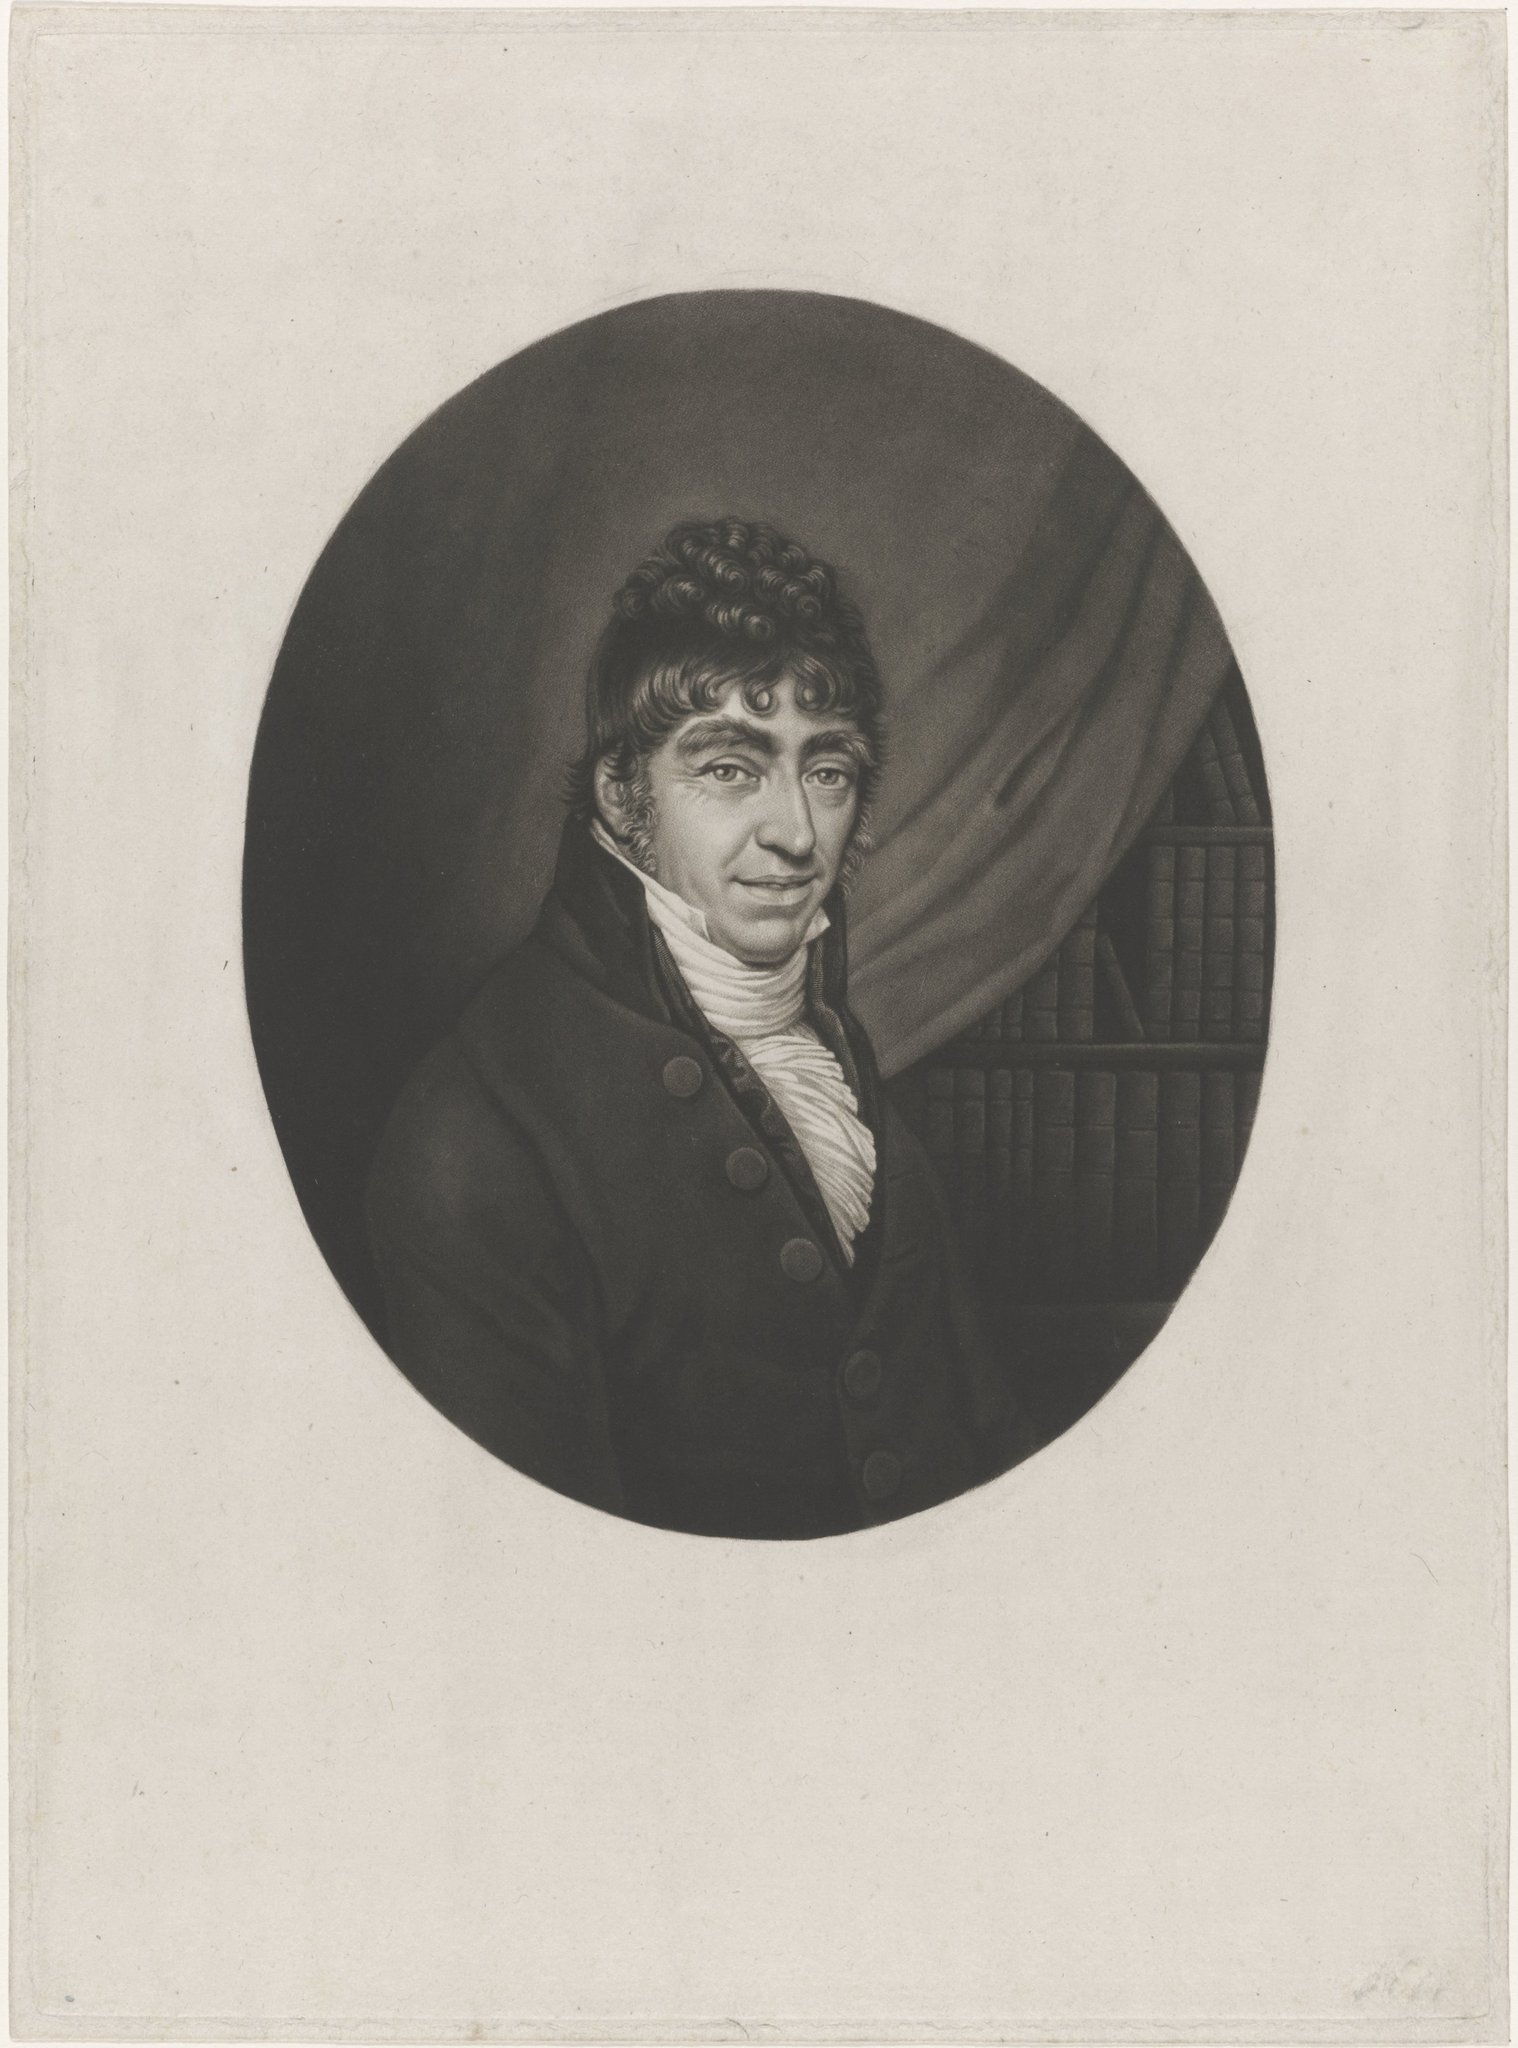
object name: print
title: Portret van Willem Bilderdijk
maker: willem grebner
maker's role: draughtsman, print maker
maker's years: 1784-1866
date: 1794-1866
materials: paper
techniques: mezzotint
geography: amsterdam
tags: amsterdam, haarlem, print maker, draughtsman, willem bilderdijk, book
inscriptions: collector's mark: Lugt 2228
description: De geschiedschrijver, taalkundige, dichter en advocaat Willem Bilderdijk. Op de achtergrond een boekenkast.